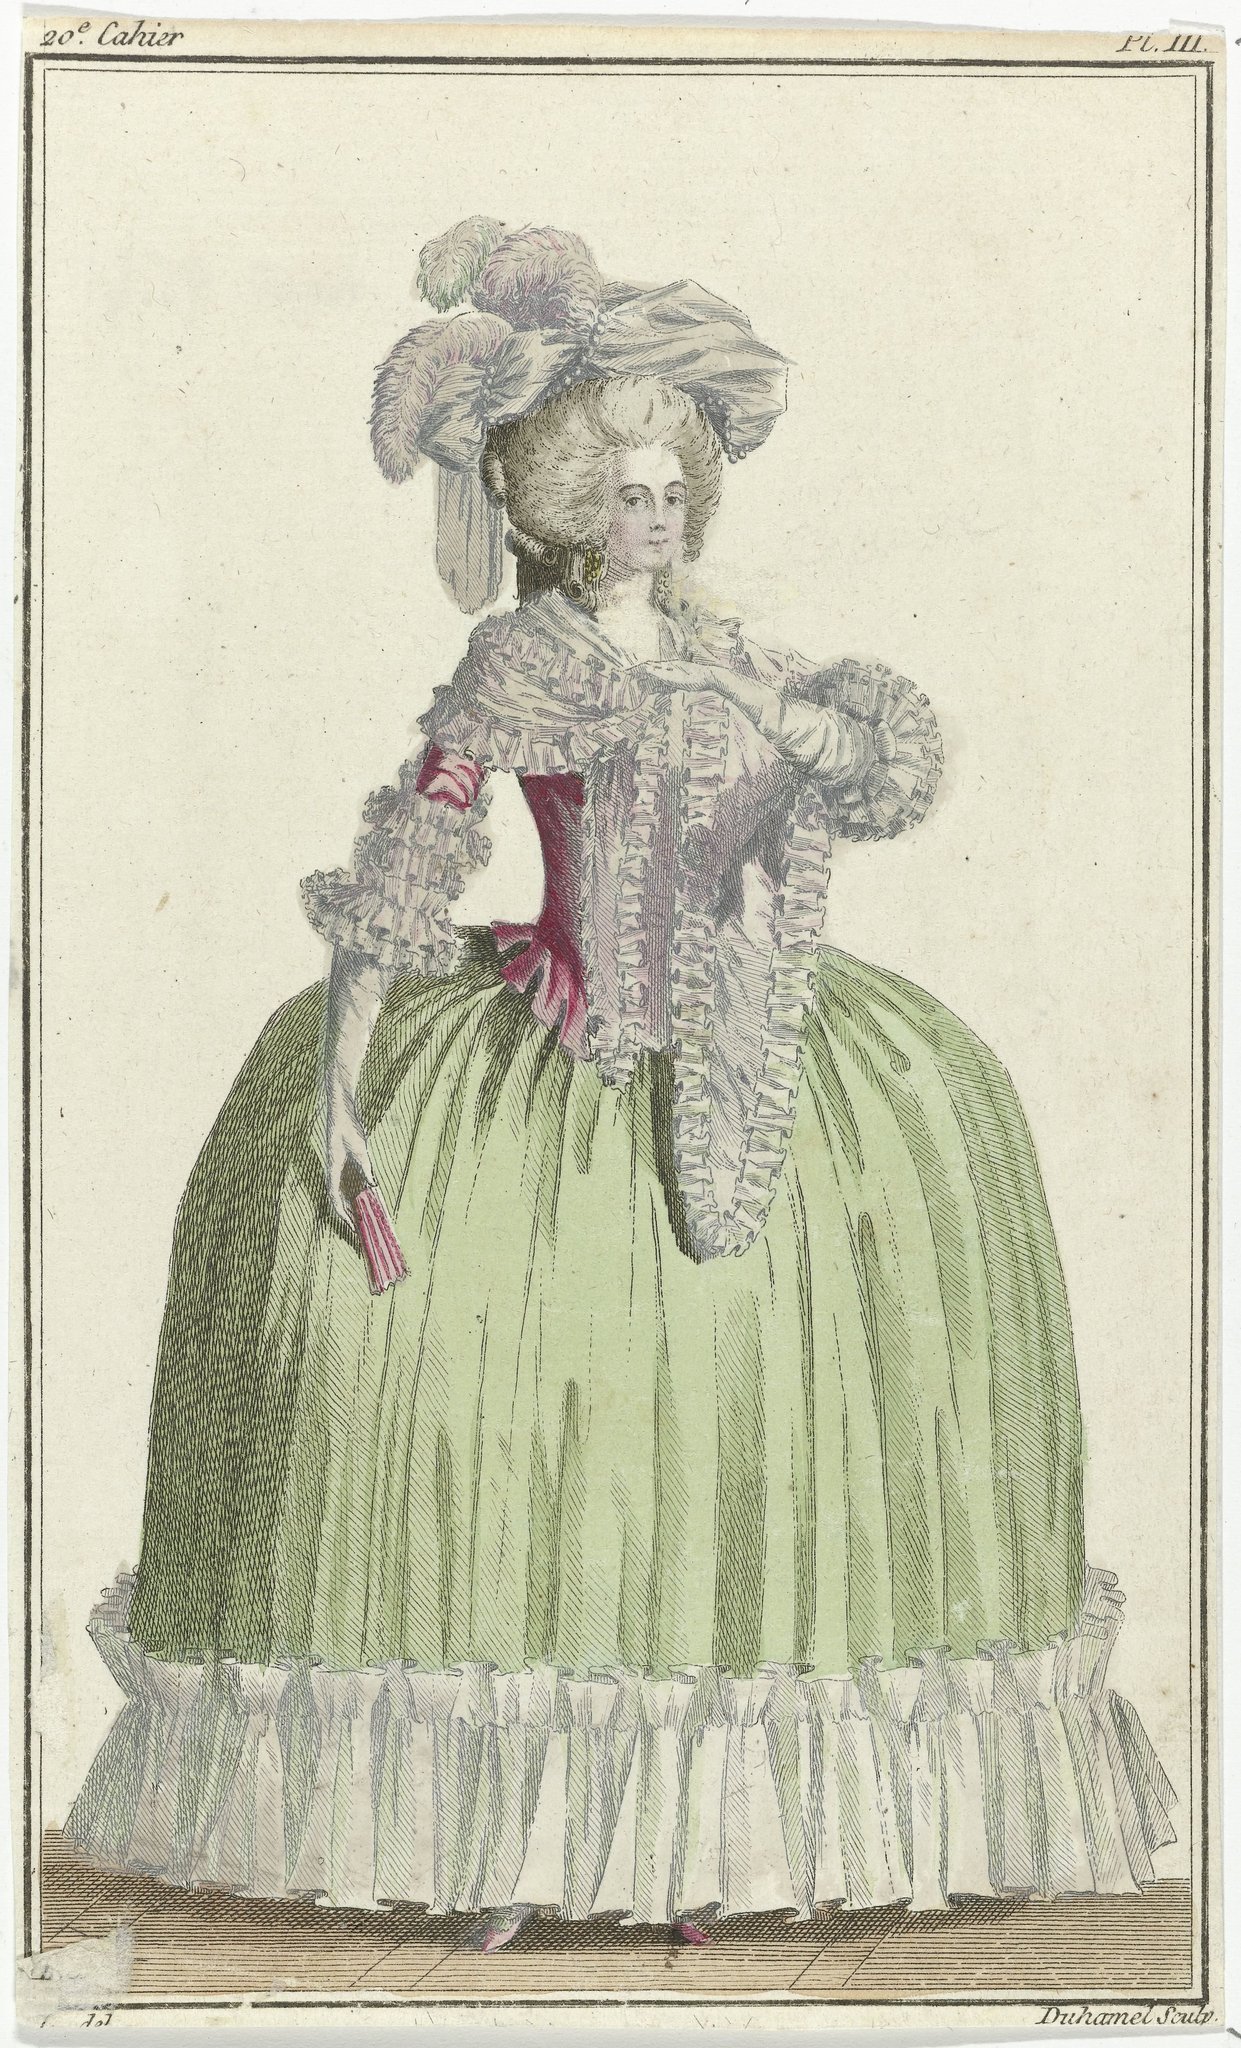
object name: fashion print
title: Cabinet des Modes ou les Modes Nouvelles, 1 septembre 1786, pl.III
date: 1786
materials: paper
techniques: engraving, hand coloring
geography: paris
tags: ear-rings (+ women's clothes), dress, gown: court gown or court dress (+ women's clothes), gloves, mittens (long gloves) (+ women's clothes), clothing for the upper part of the body (mantelet) (+ women's clothes), styles of hairdress - aa - ~ women, head-gear: cap (+ women's clothes), fashion plates, skirt (+ women's clothes), sleeves (+ women's clothes)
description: Vrouw in een hofjapon, bestaande uit een lijfje van roze tafzijde en rok van appelgroene tafzijde. Hierop een doorzichtige kleine schoudermantel van tule, afgezet met gerimpelde stroken. Accessoires: muts van tule met veren en parels, oorbellen, lange handschoenen, vouwwaaier. De prent maakt deel uit van het 20e Cahier uit Cabinet des Modes ou les Modes Nouvelles. De serie bestaat uit 72 modeprenten, uitgegeven door Buisson, Parijs, 15 november 1785 - 1 november 1786.